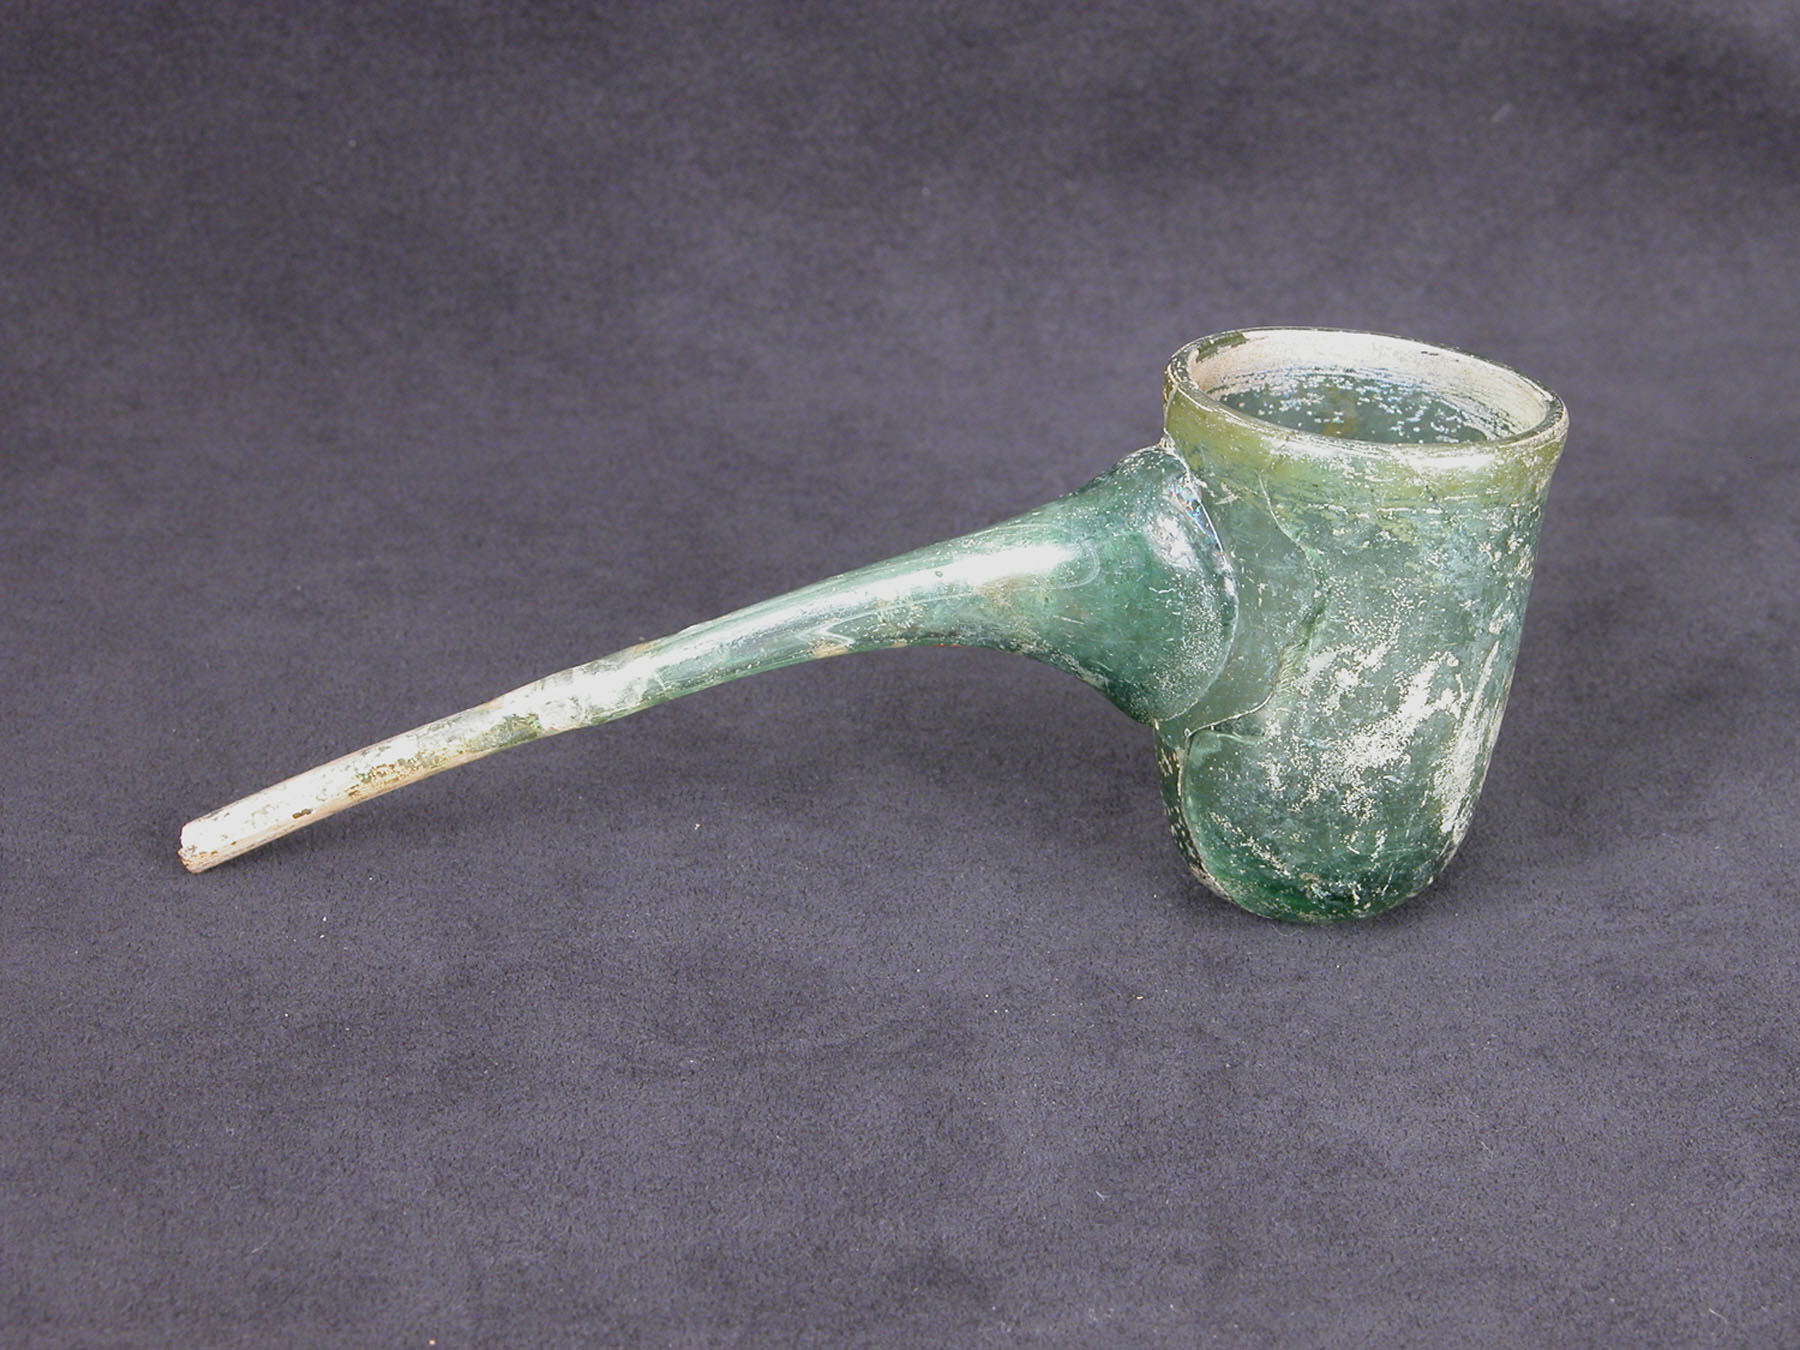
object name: alembic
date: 801-1100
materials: glass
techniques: glassblowing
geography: iran